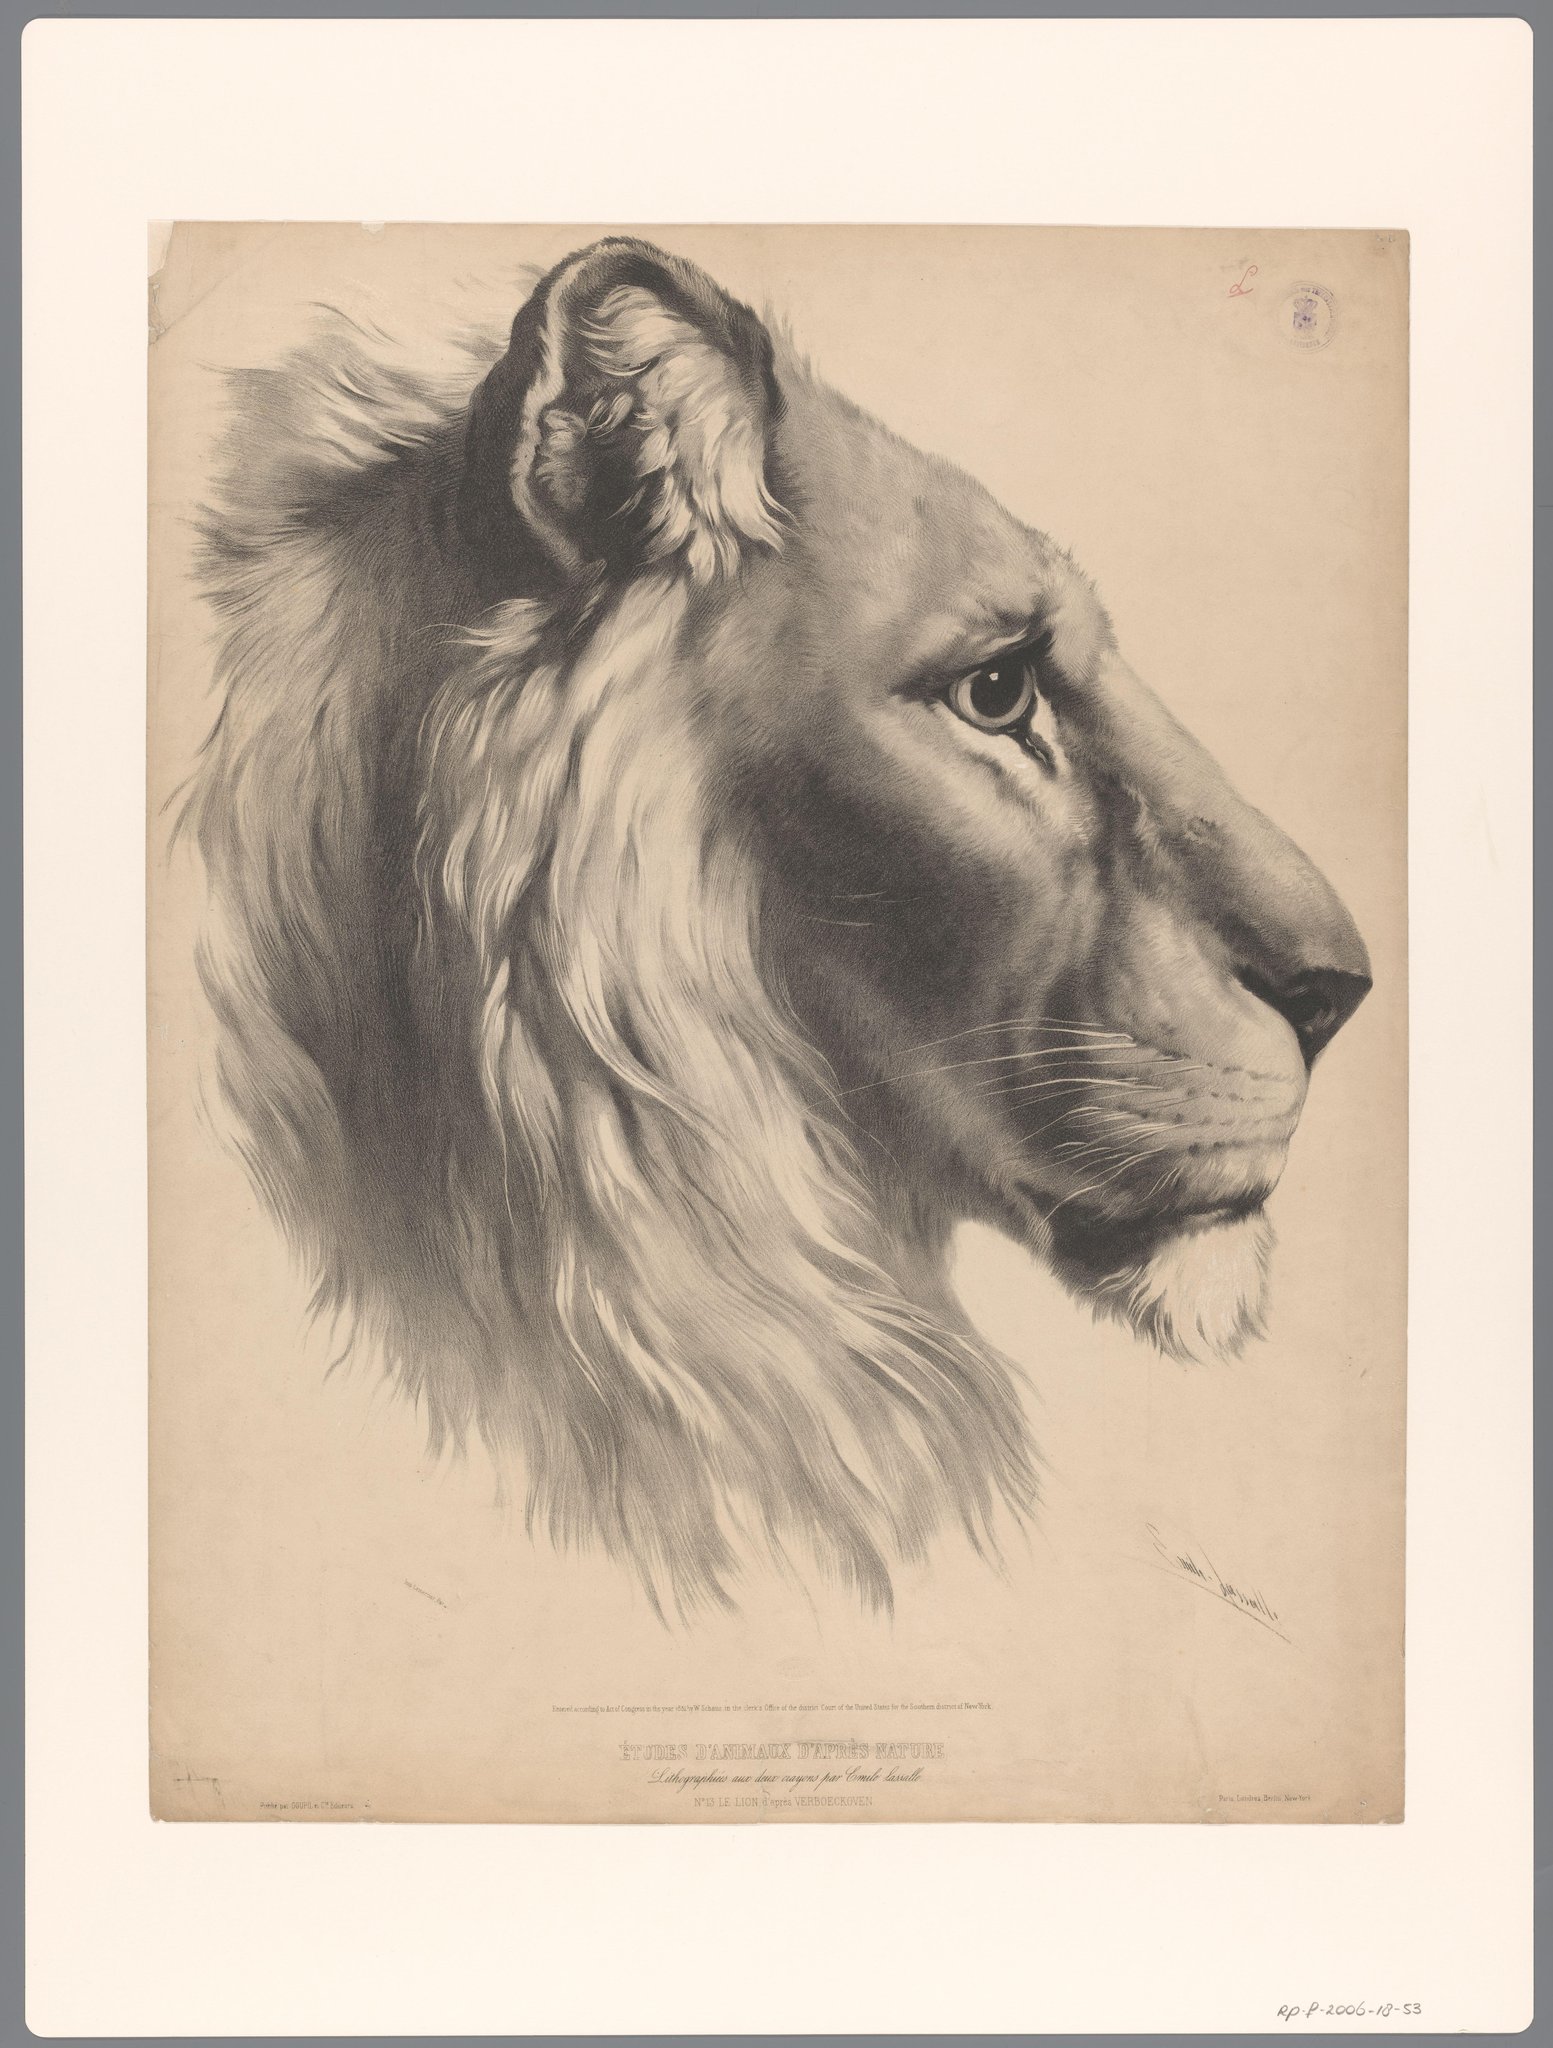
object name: print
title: Leeuwenkop, en profil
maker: émile lassalle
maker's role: print maker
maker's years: 1813-1871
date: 1825-1900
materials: paper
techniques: lithograph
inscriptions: collector's mark, : ‘Imp Lemercier, Paris / Emile Lassalle / Entered according to Act of Congress in the year 1825 by W. Schaus in the clerk's Office of the district Court of the United States for the Southern district of New York / ÉTUDES D'ANIMAUX D'APRÈS NATURE / Lithographiées aux deux crayons par Emile Lassalle / No 13 LE LION d'après VERBOECKOVEN / Publié par GOUPIL &Cie Editeurs Paris, Londres, Berlin, New-York’